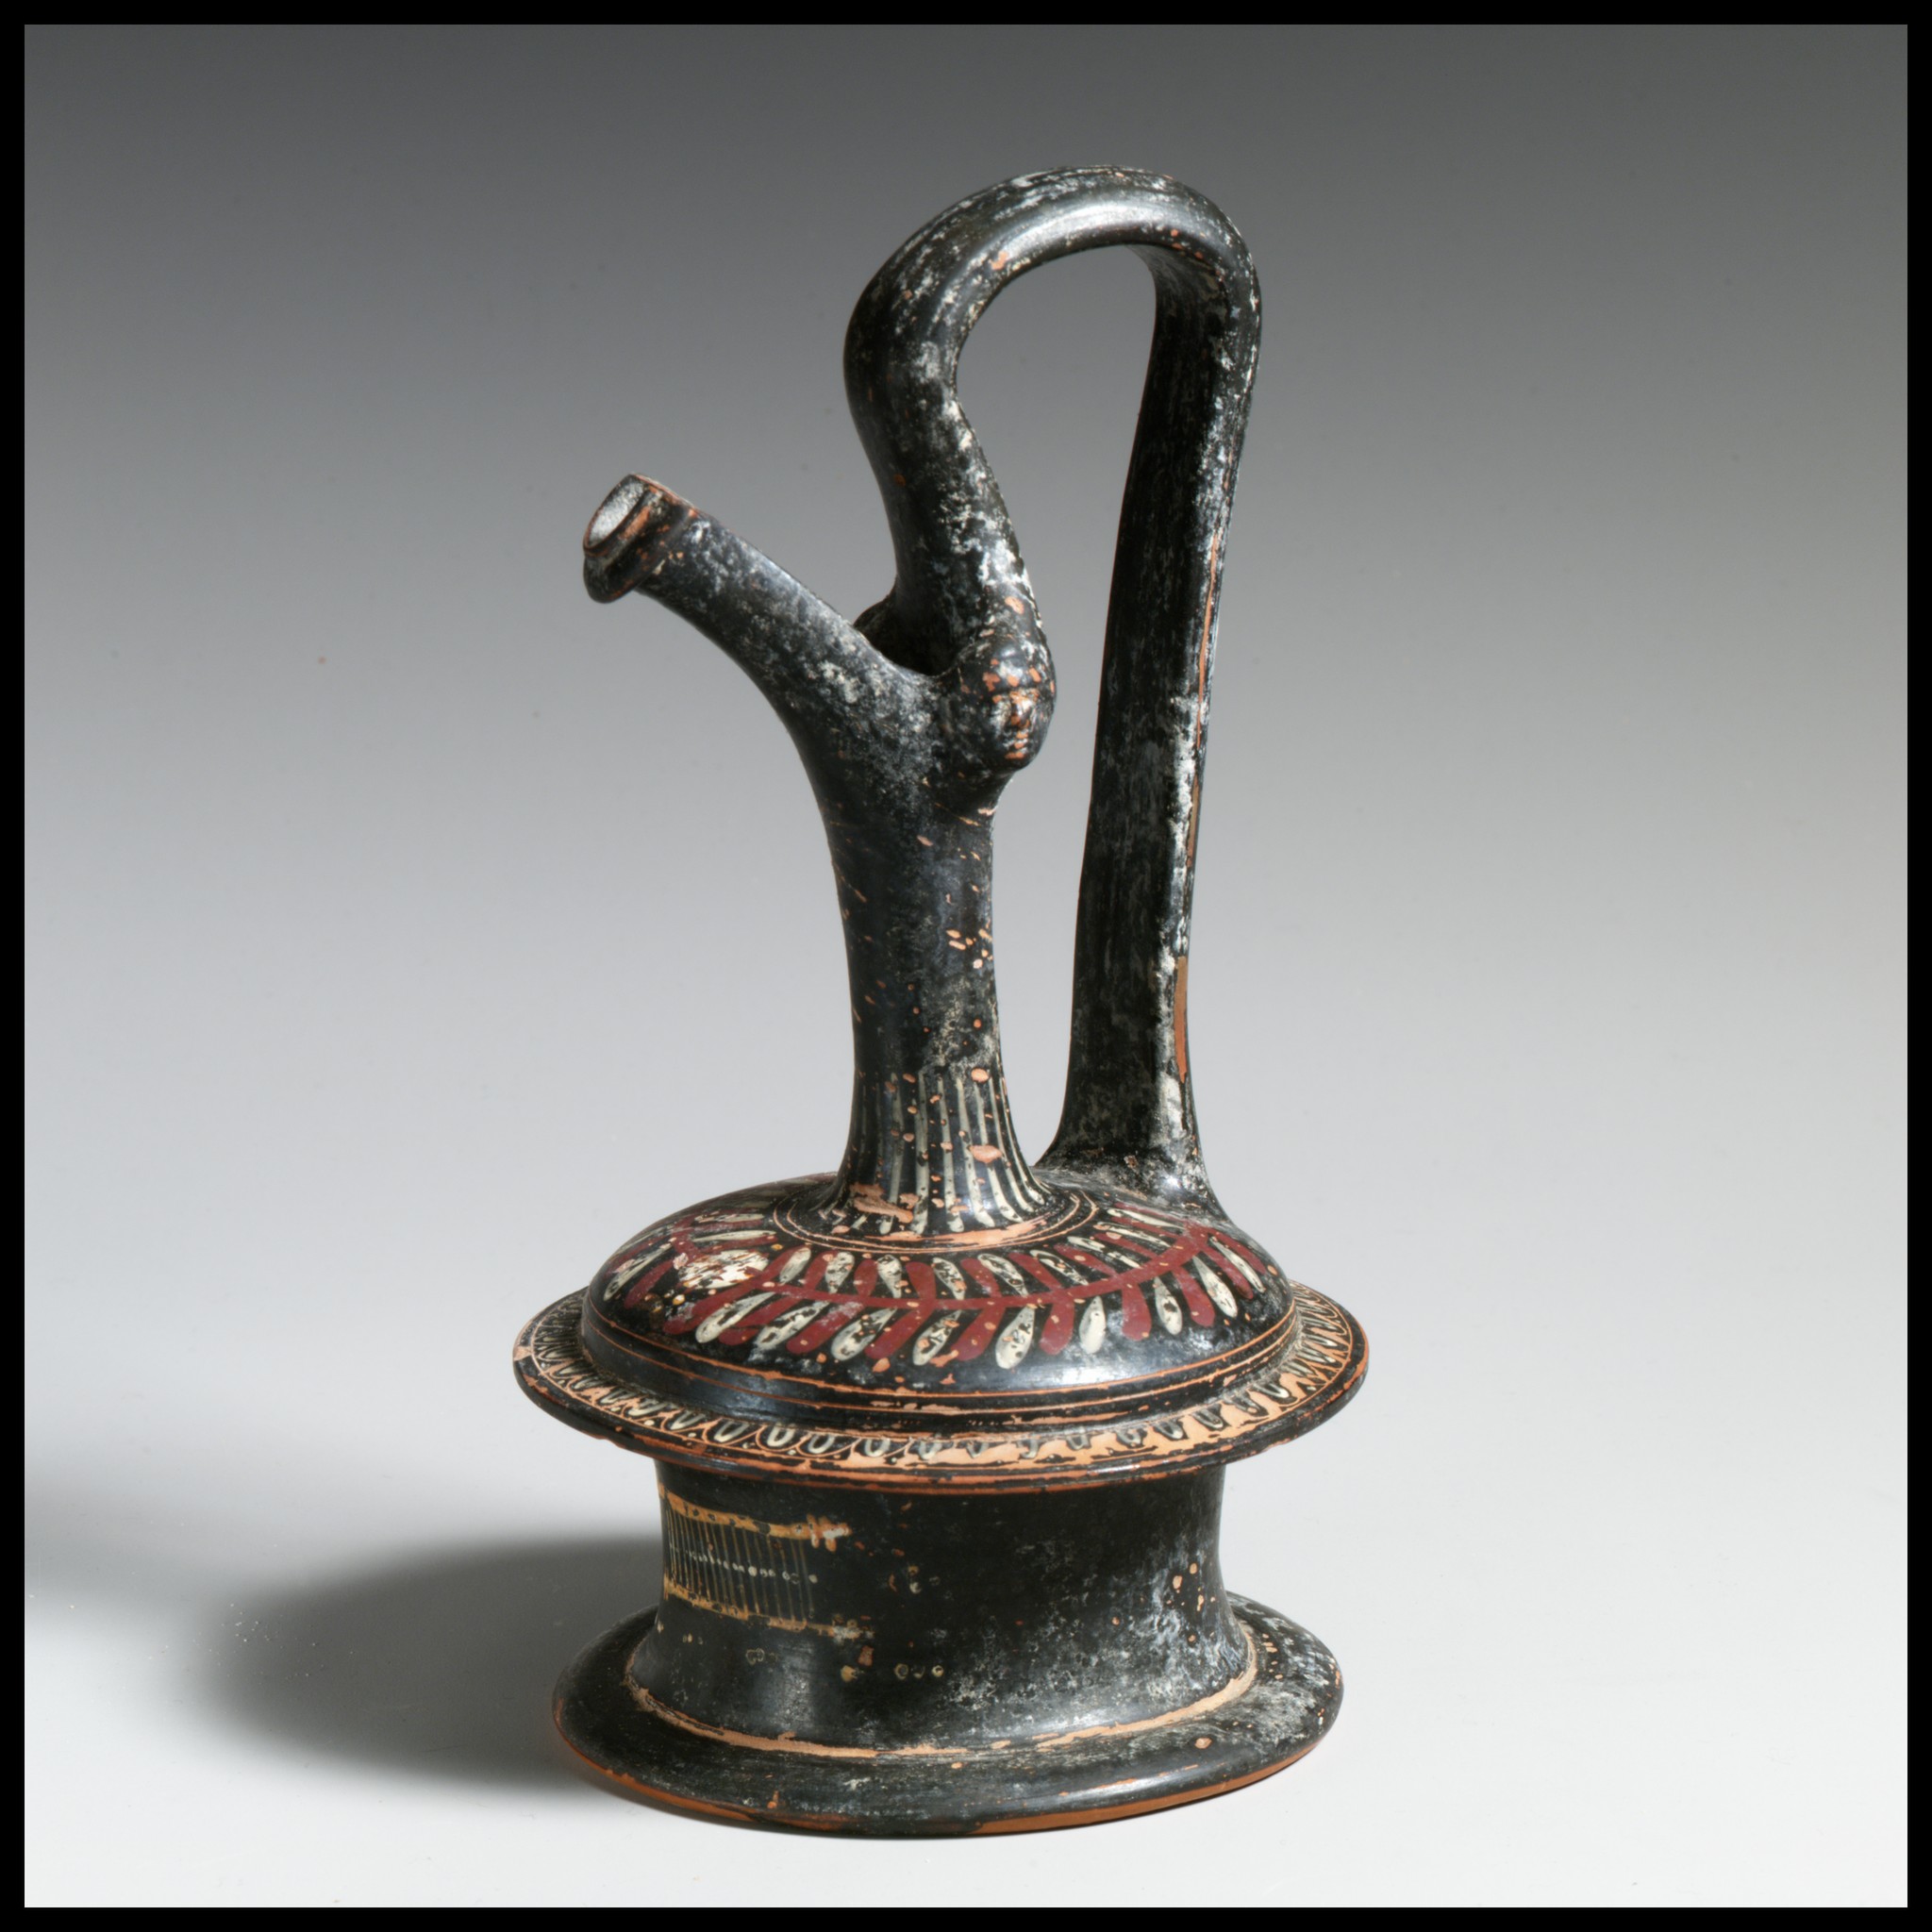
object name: epichysis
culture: greek, south italian, apulian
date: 325-300 BCE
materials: terracotta